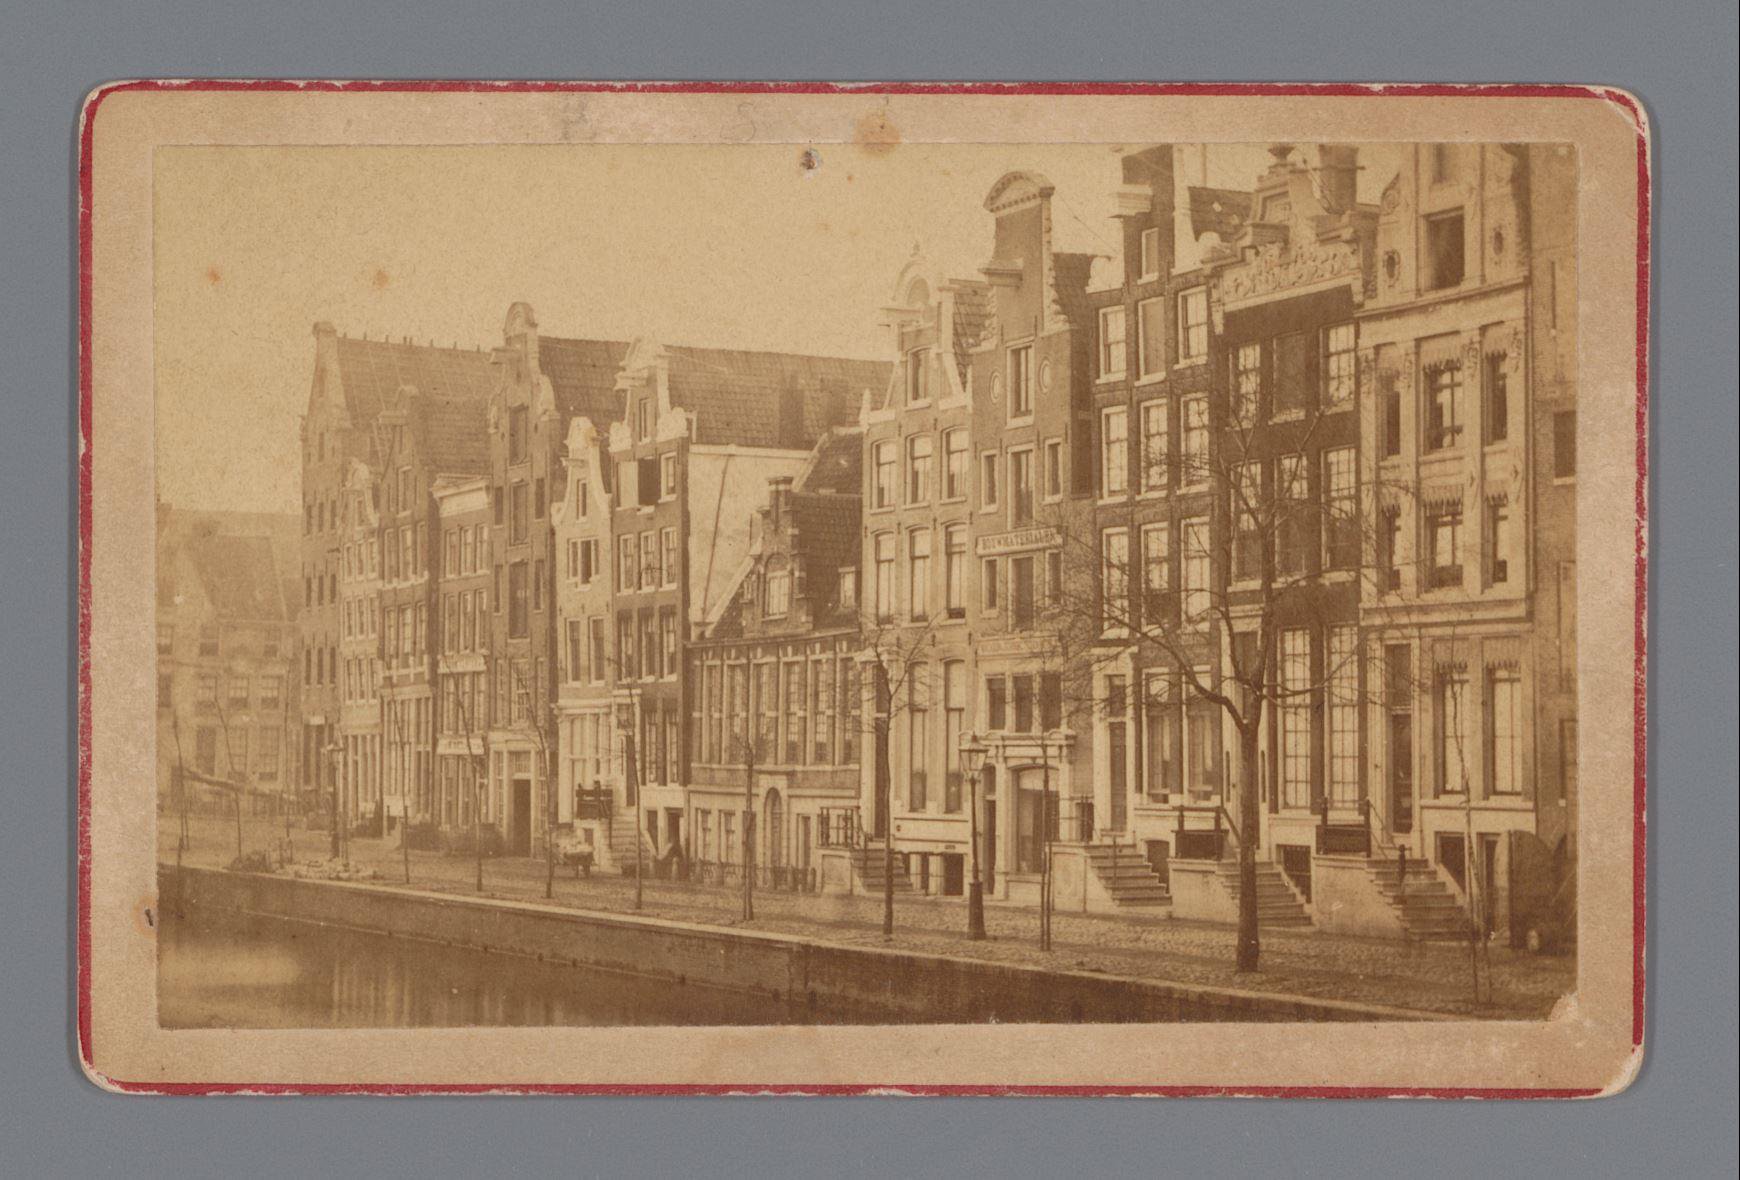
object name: photograph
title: Gezicht op woningen aan een gracht te Amsterdam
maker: Anonymous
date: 1860-1900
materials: cardboard, photographic support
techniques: albumen print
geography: amsterdam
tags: canals, waters (in city), the usual house or row of houses, amsterdam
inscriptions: annotation: ‘Amsterdam’, collector's mark: ‘Algemeene boekhandel/ C.F. Stemler/ Haarlemmerdijk/ hoek Singel T.T. 2/ Amsterdam’